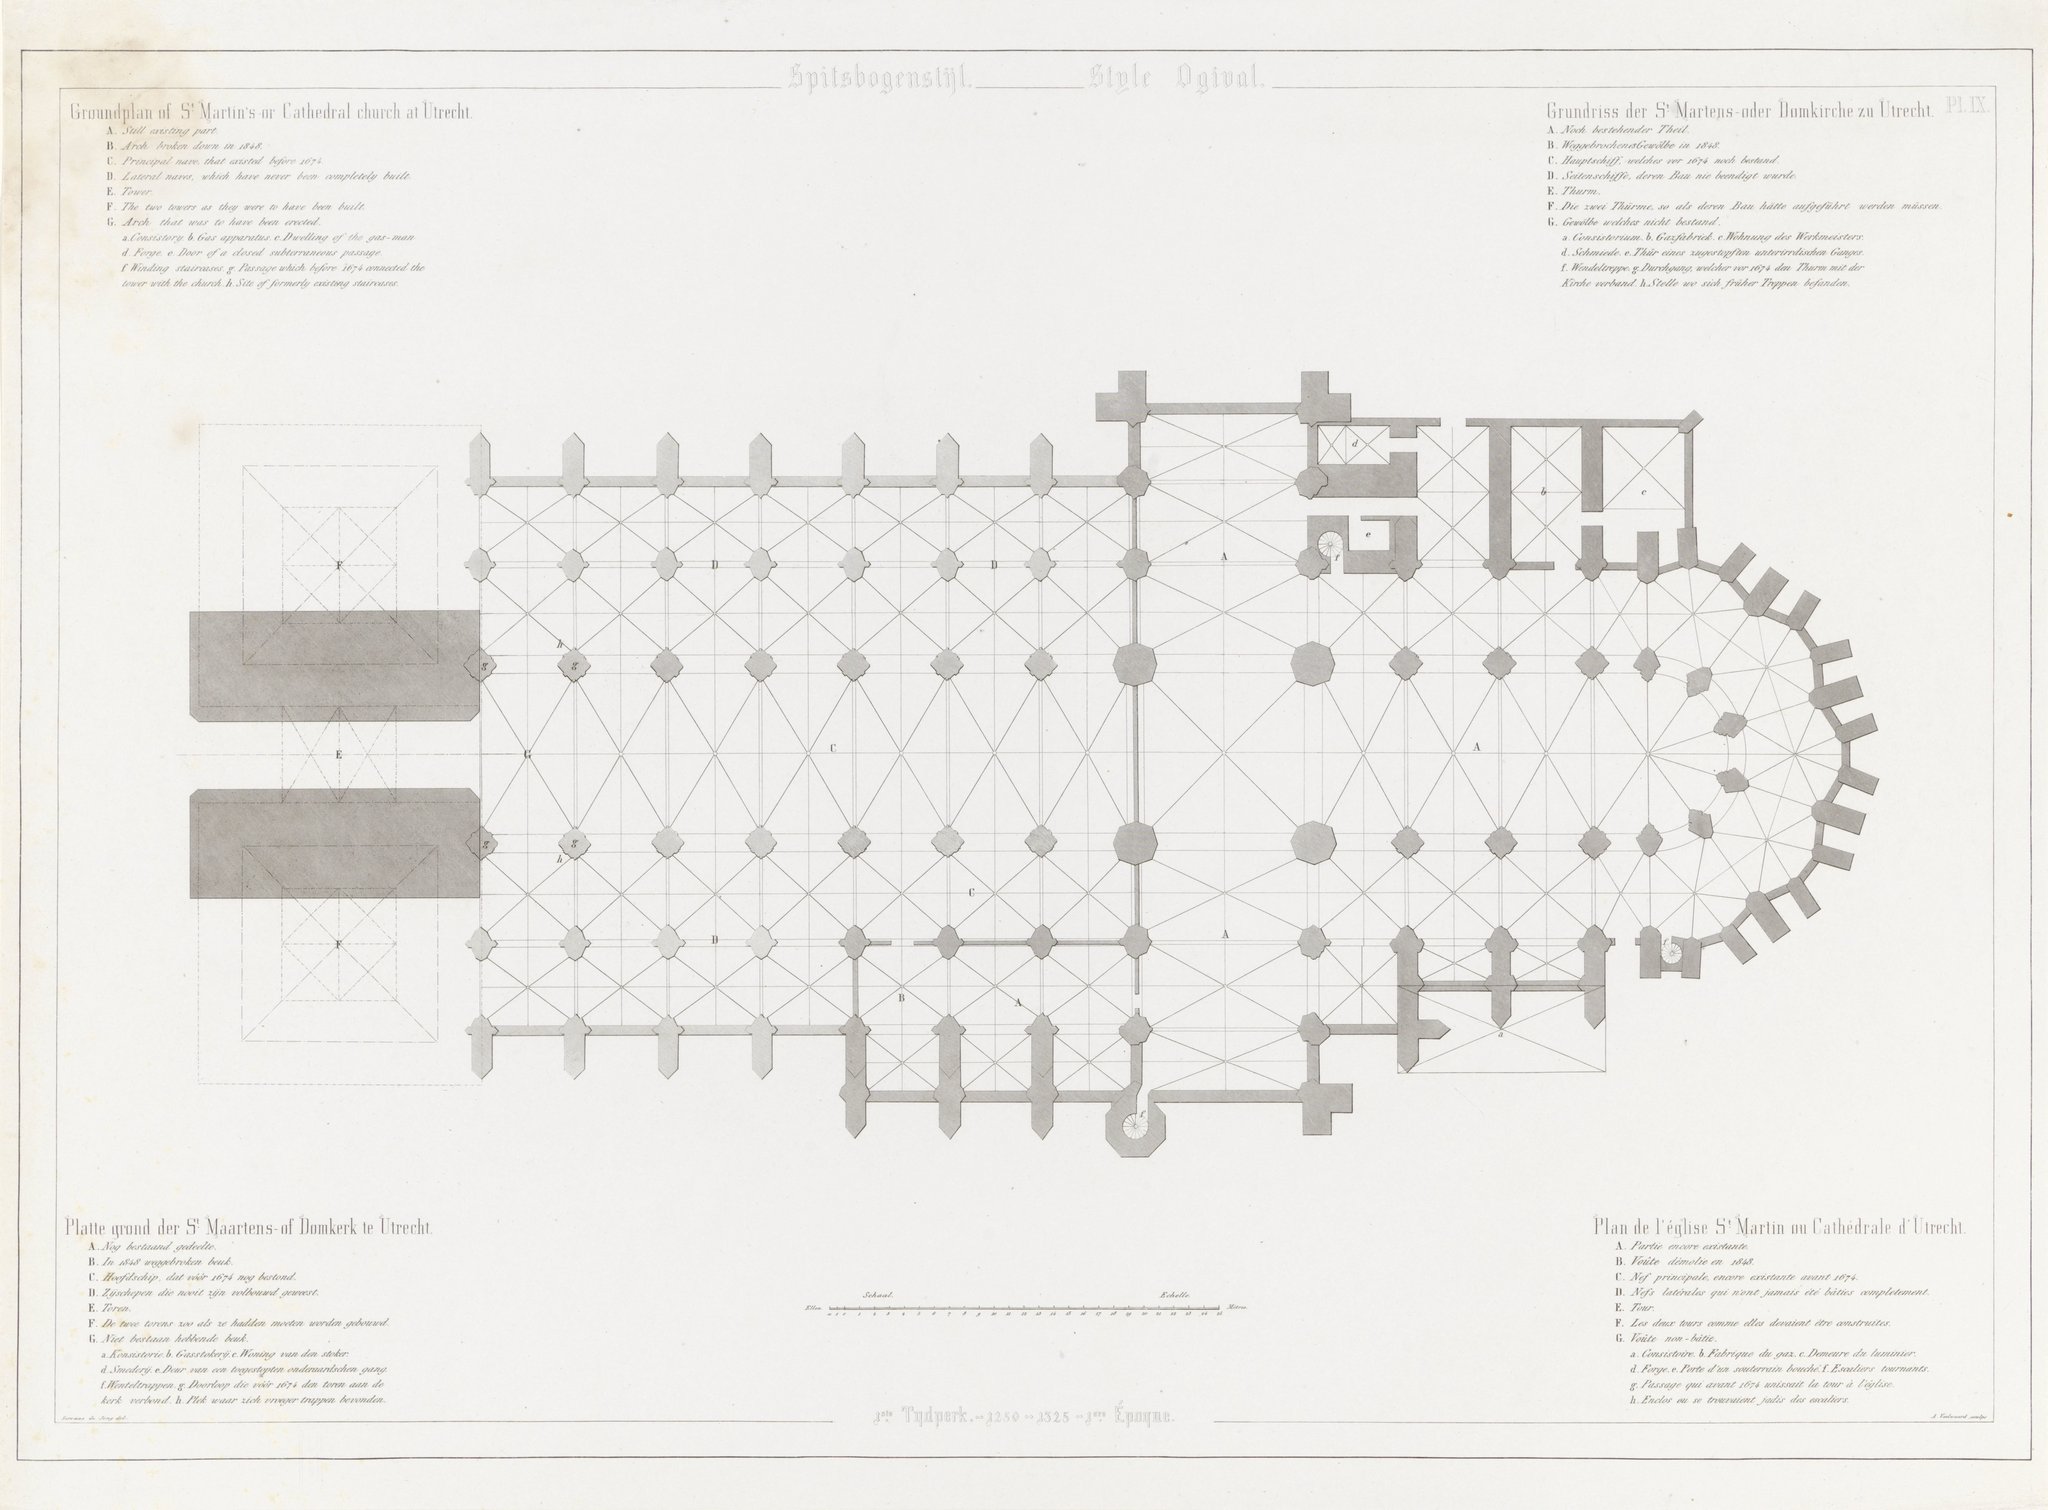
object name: print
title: Plattegrond van de Domkerk te Utrecht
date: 1816-1873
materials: paper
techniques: etching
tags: plan ~ architecture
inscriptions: collector's mark: Lugt 2228